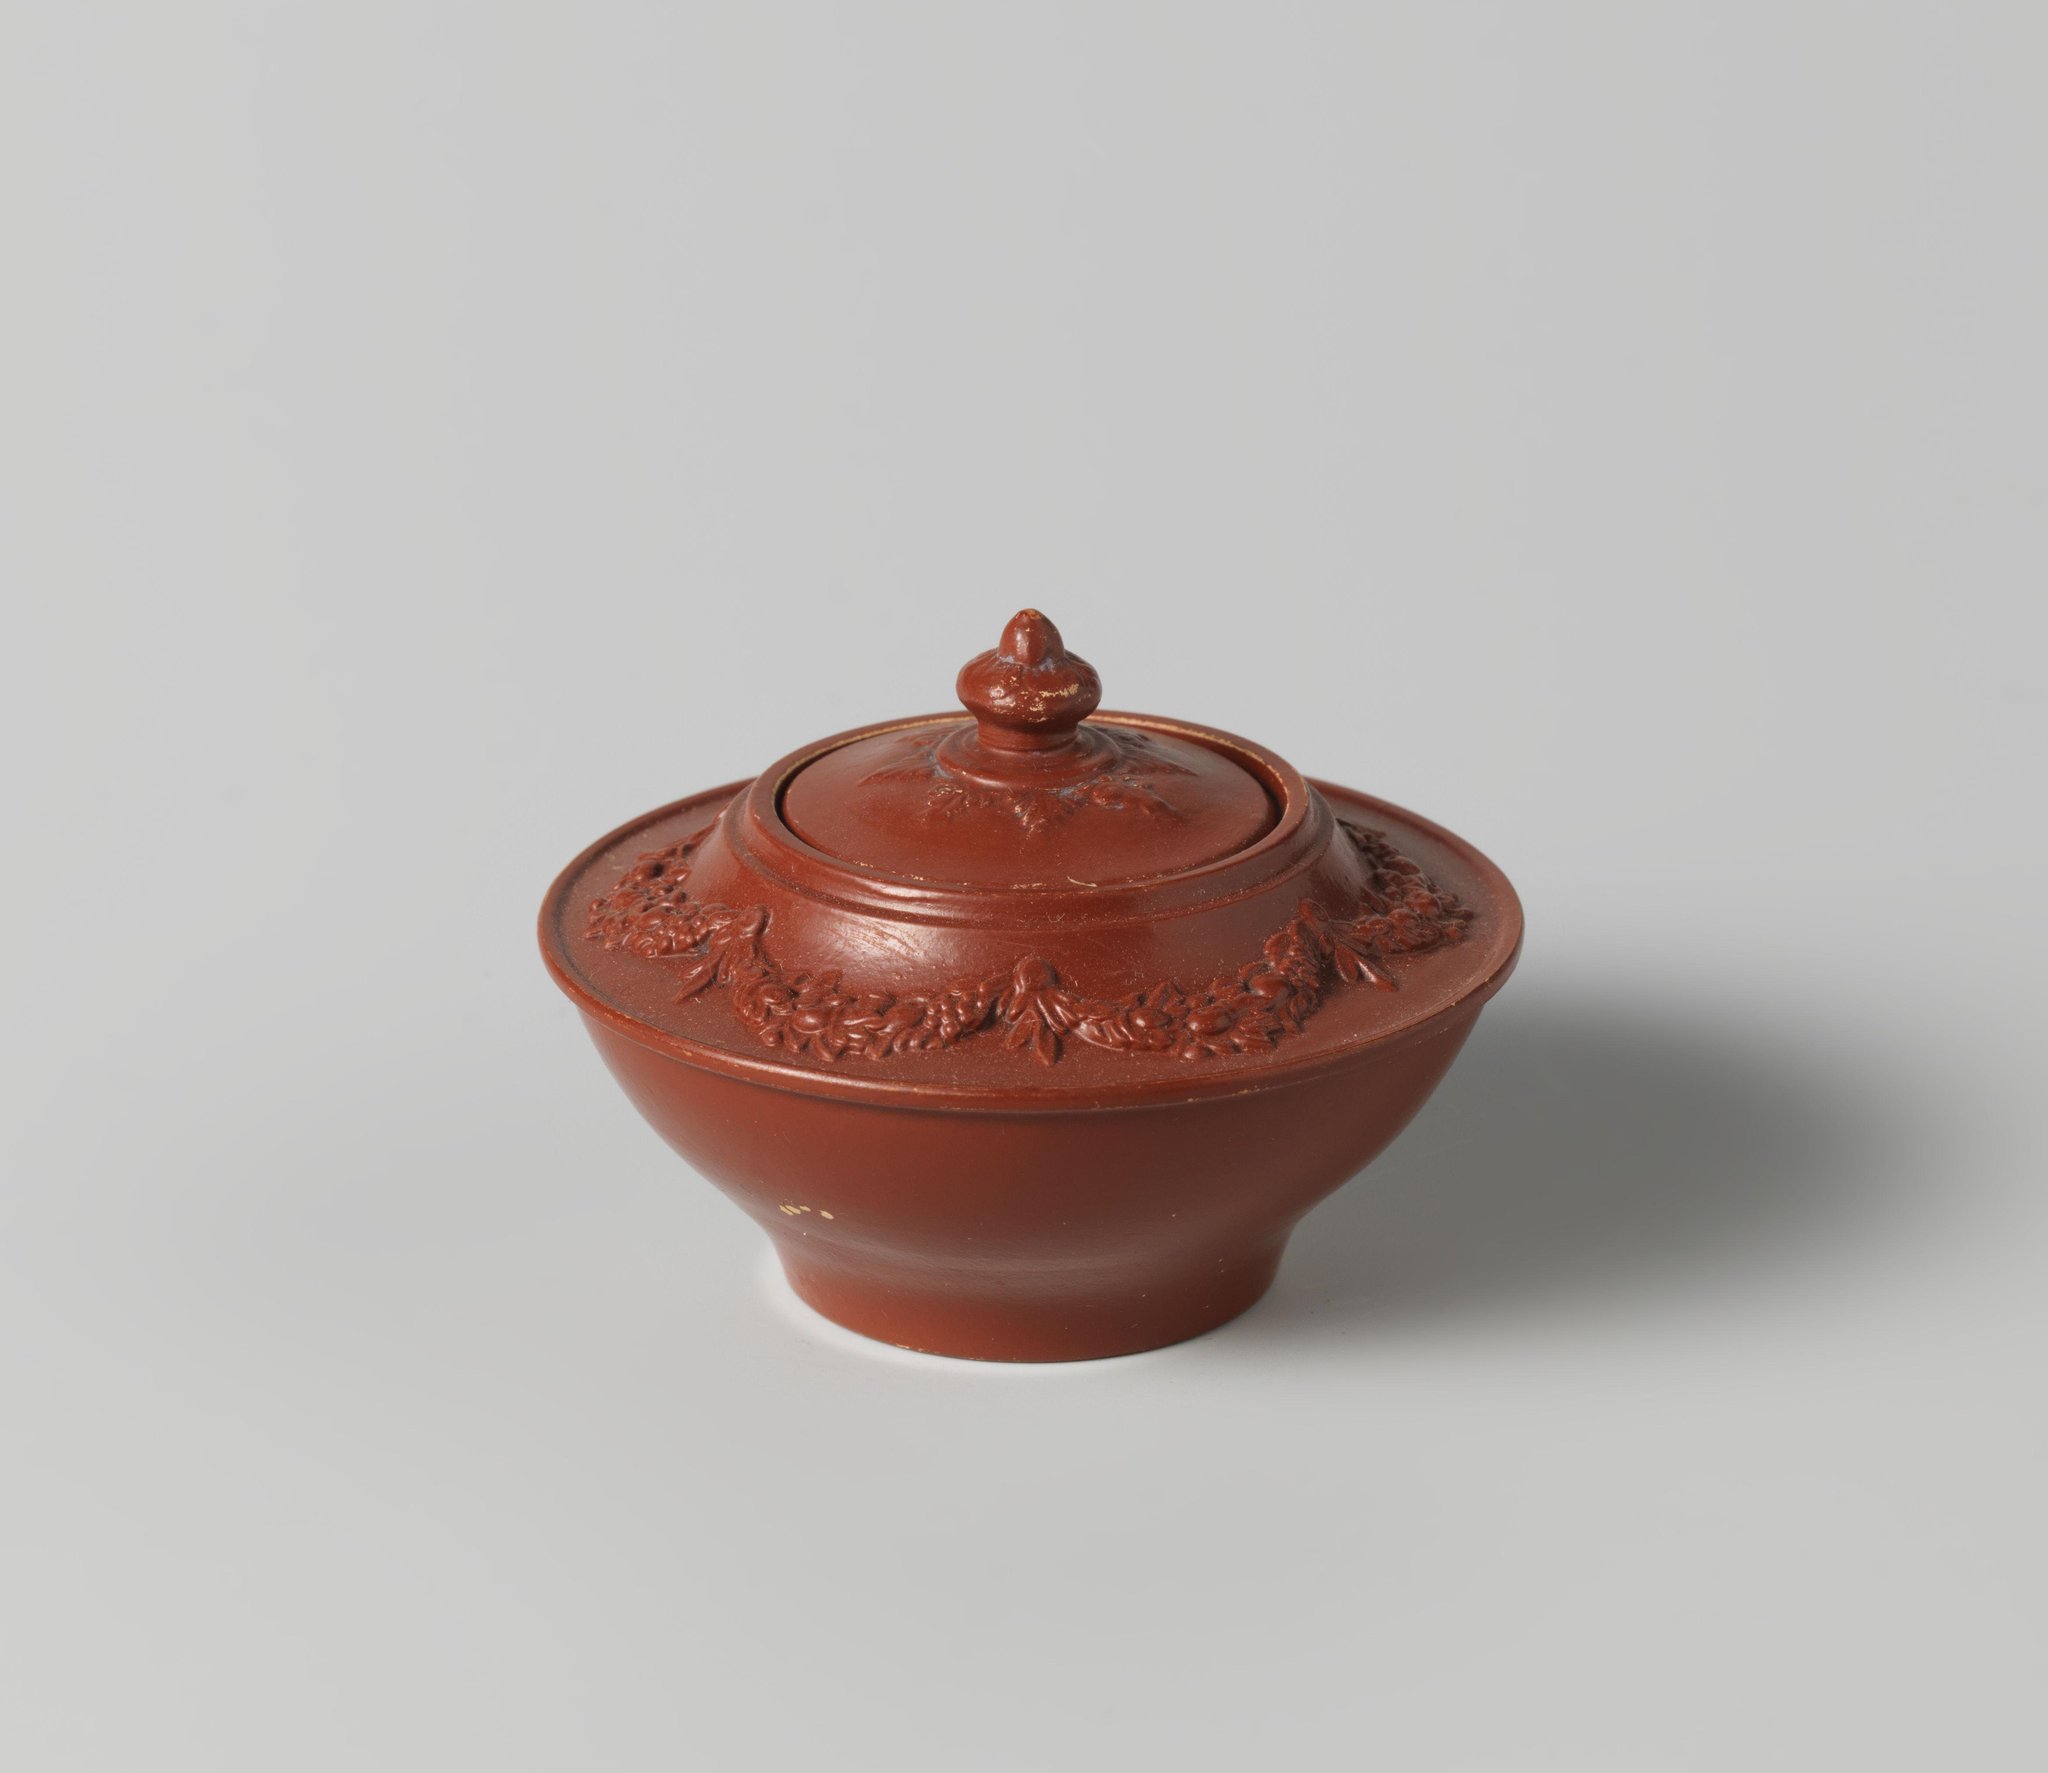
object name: sugar box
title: Suikerpot van rood hardgebakken aardewerk, kinderspeelgoed.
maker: Anonymous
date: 1830-1860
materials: earthenware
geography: bohemia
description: Halfbolvormige suikerpot van rode, hardgebakken aardewerk. De pot heeft een standring. De suikerpot is in reliëf vesierd met guirlandes van bladeren en vruchten. De suikerpot hoort bij een miniatuur theeservies (BK-15429-A t/m BK-15429-D).